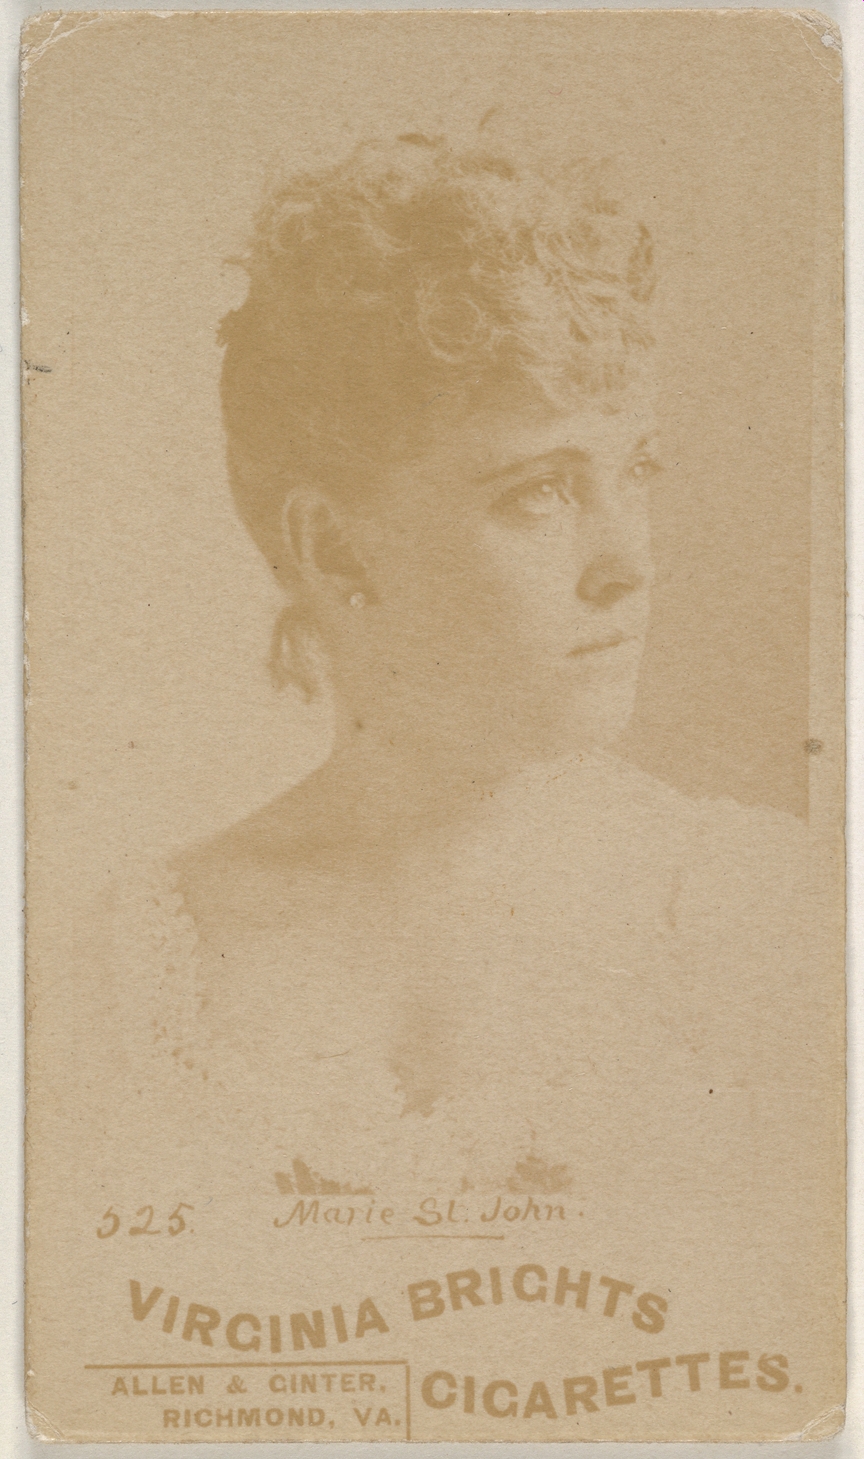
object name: photograph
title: Card 525, Marie St. John, from the Actors and Actresses series (N45, Type 6) for Virginia Brights Cigarettes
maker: allen & ginter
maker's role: publisher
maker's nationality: american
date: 1888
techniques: albumen silver print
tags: portraits,women,actresses